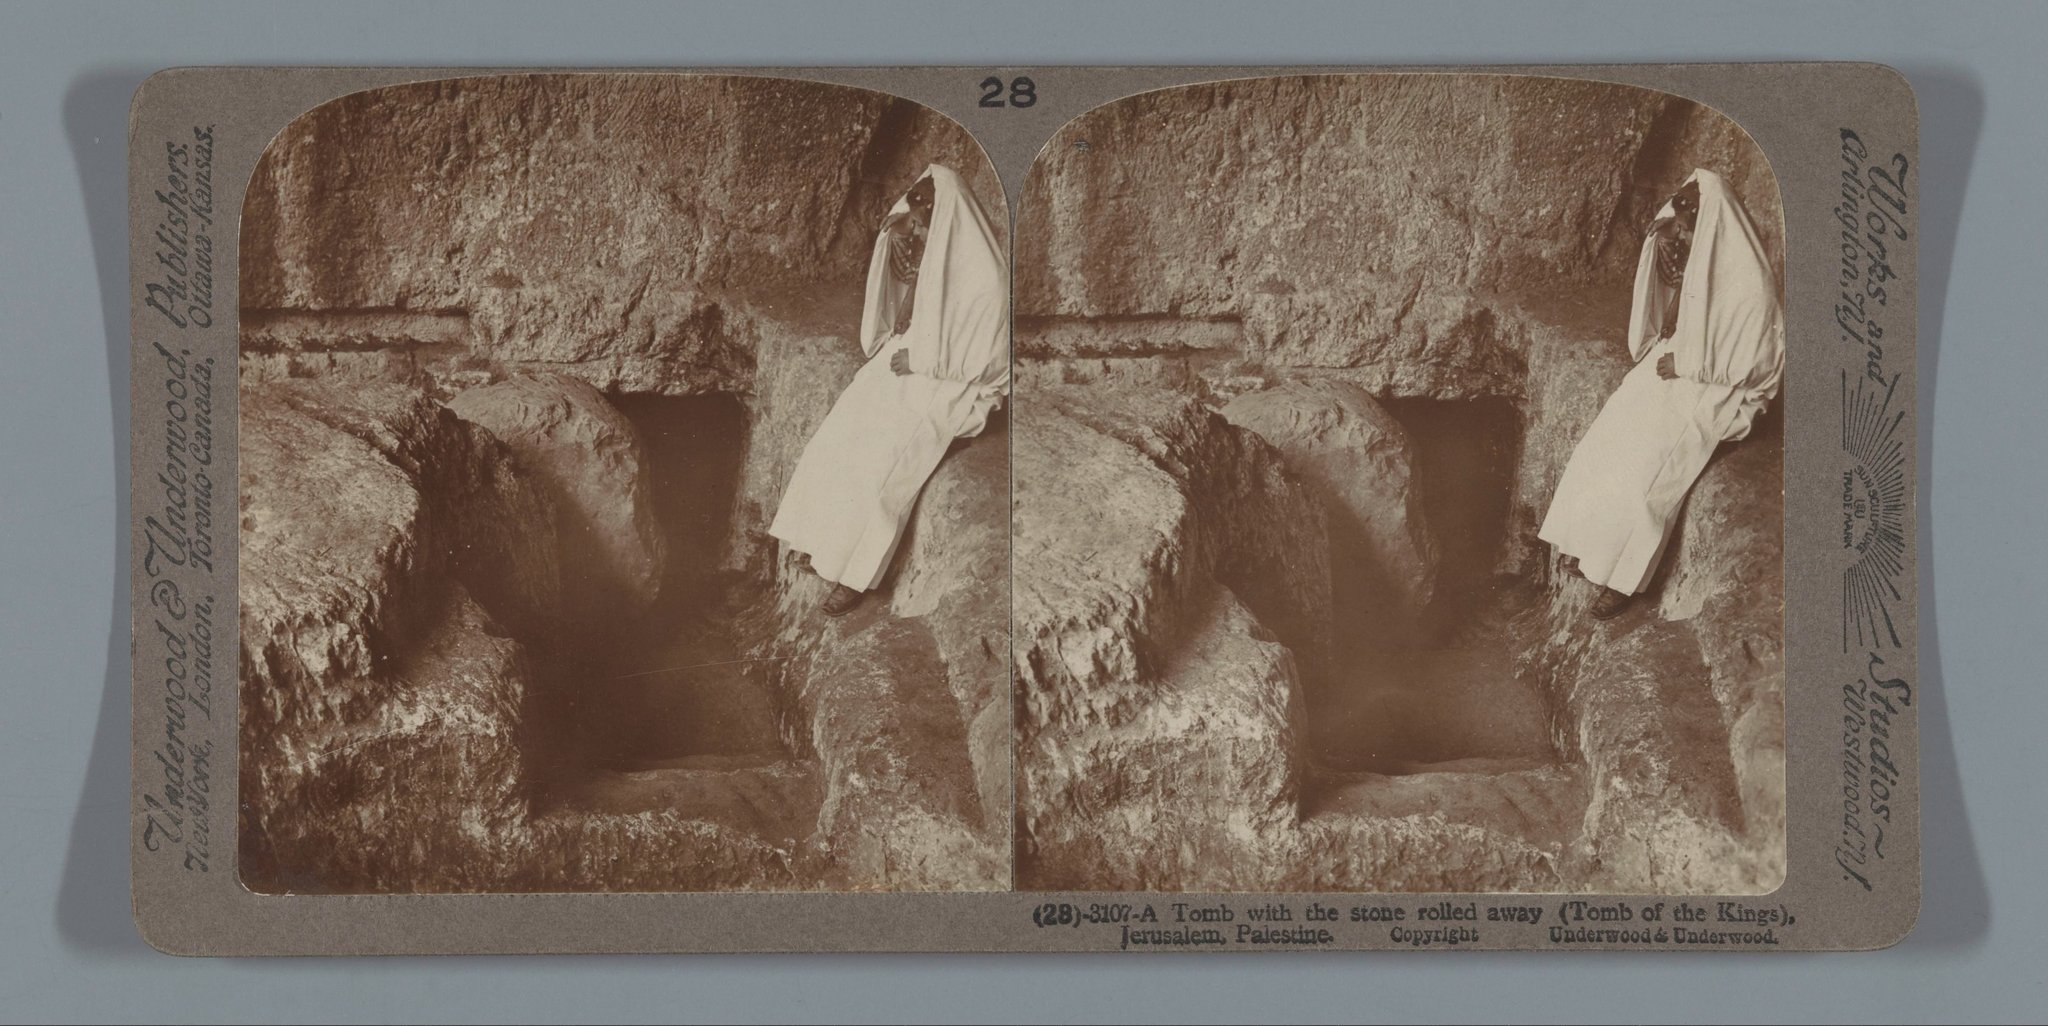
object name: stereograph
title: A Tomb with the stone rolled away (Tomb of the Kings), Jerusalem, Palestine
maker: Anonymous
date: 1900-1905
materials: paper, cardboard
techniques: gelatin silver print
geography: jerusalem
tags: grave hollowed out of rock, wailing-women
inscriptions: number: ‘28’, copyright notice: ‘Copyright Underwood & Underwood.’, number: ‘(28)-3107-’, inscription: ‘Works and Studios ~/ Arlington, N.J. Westwood, N.J.’, inscription